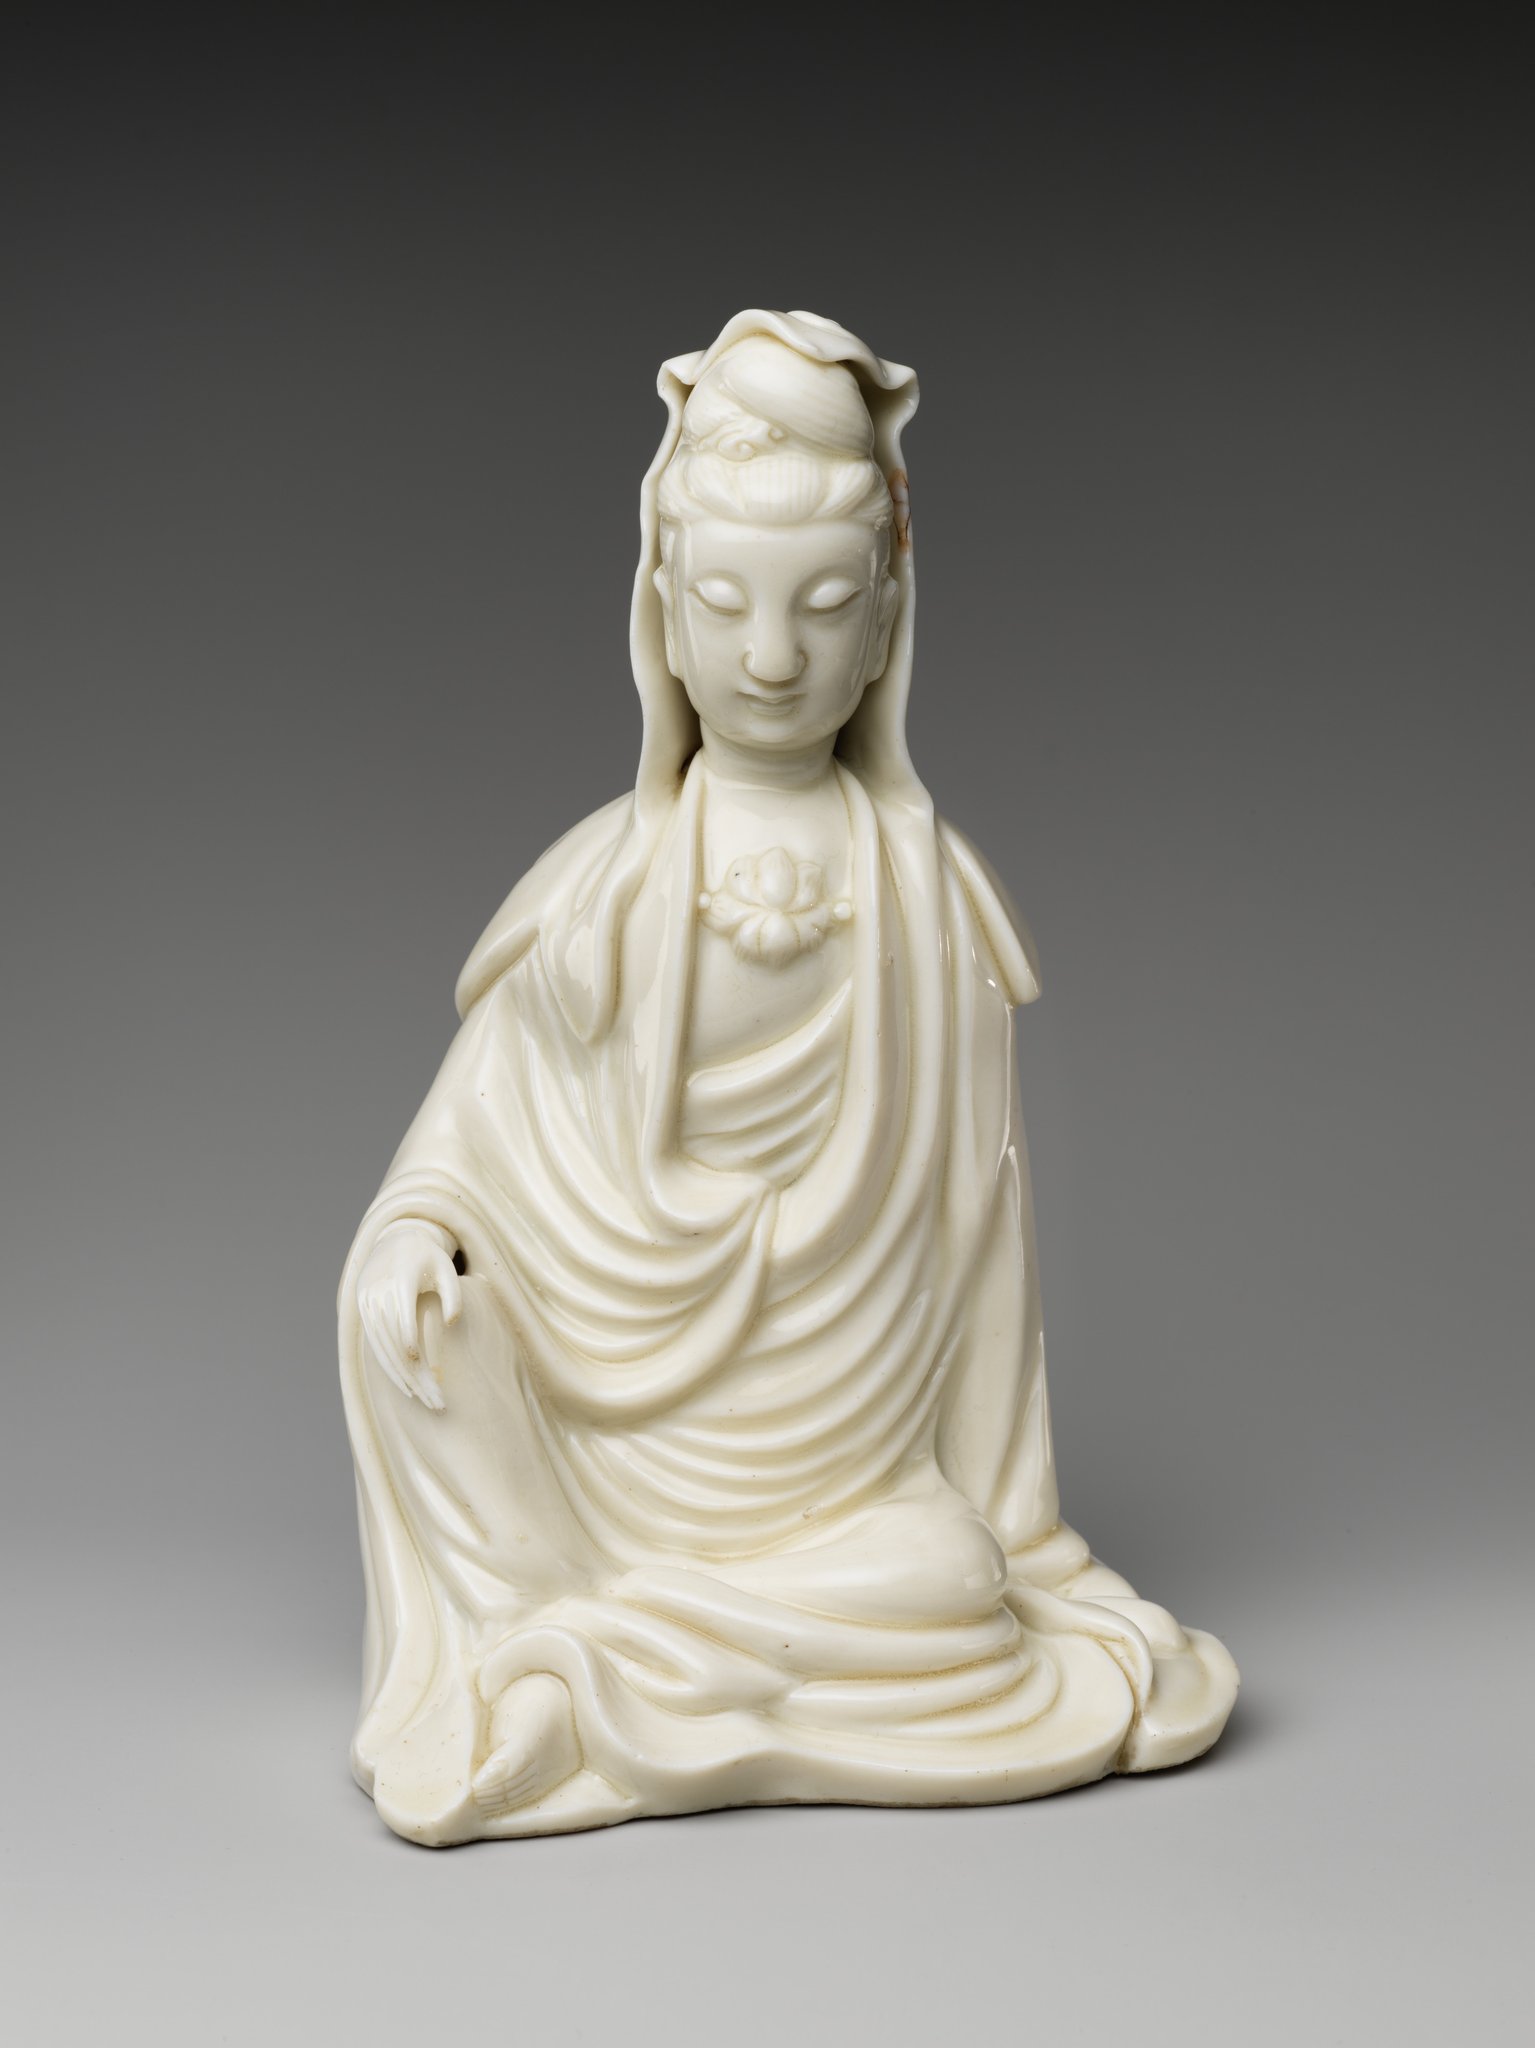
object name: figure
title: Figure of seated Bodhisattva Guanyin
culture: chinese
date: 1701-1800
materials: glaze, porcelain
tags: bodhisattvas